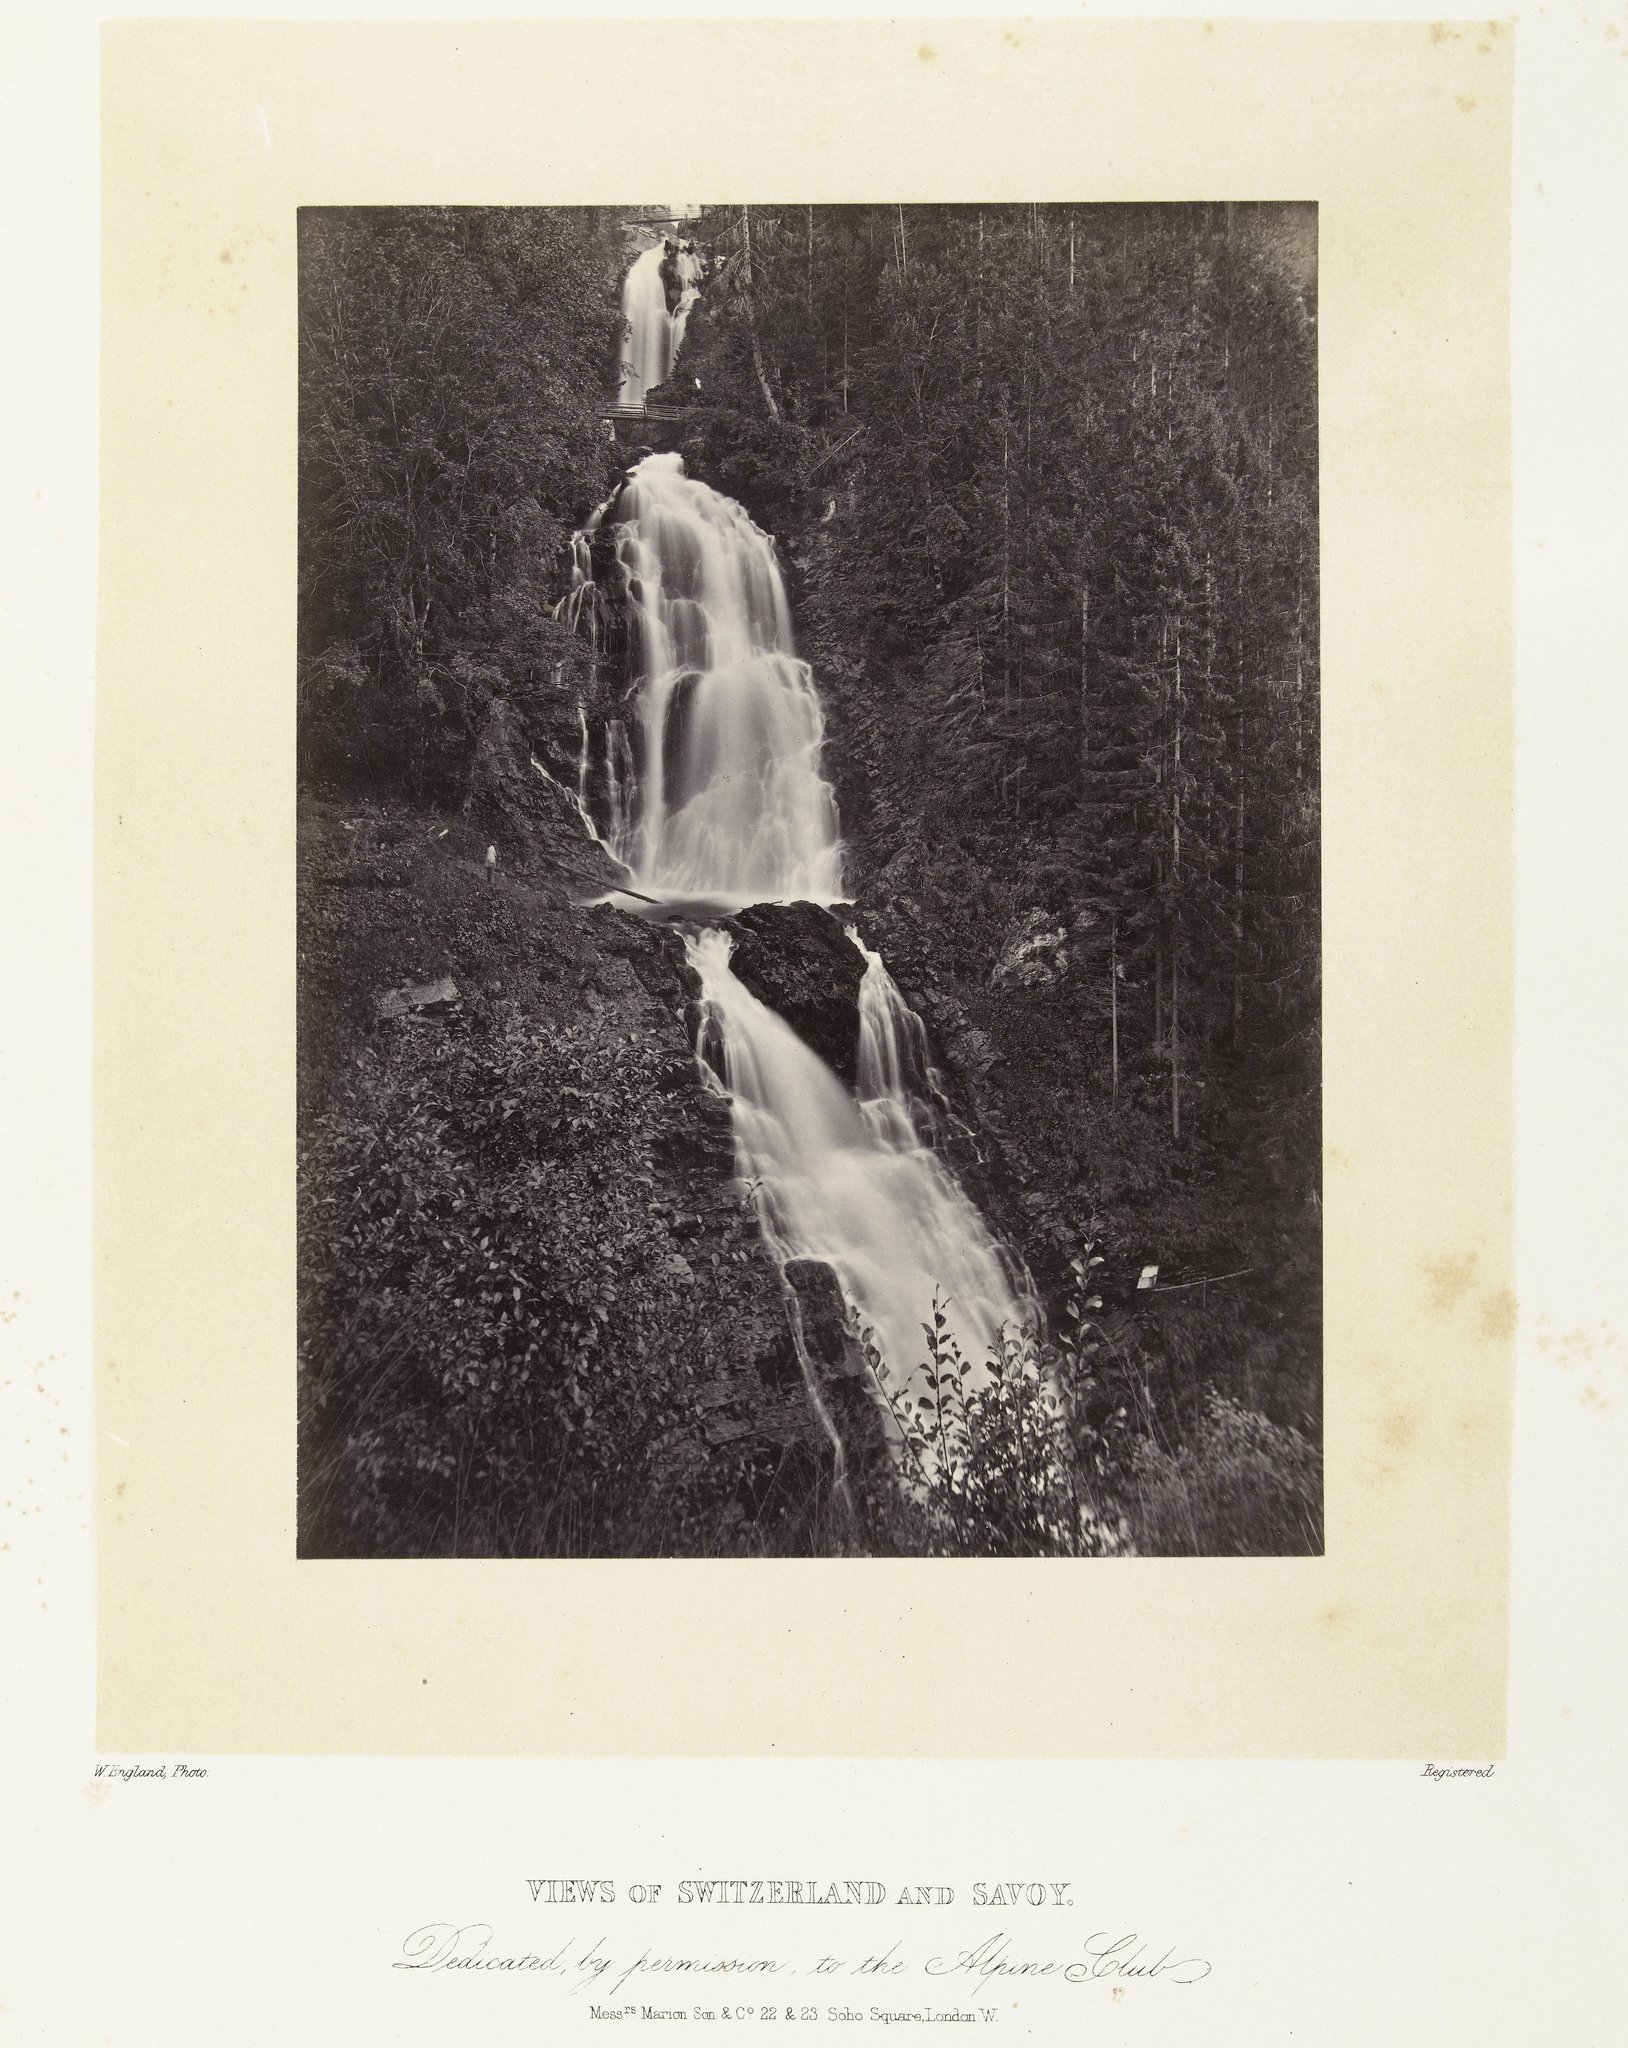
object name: photograph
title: Views of Switzerland and Savoy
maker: william england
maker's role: fotograaf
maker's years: 1816-1896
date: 1863-1865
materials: cardboard, paper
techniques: albumen print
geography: bern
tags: waterfall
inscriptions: inscription: ‘Dedicated, by permission, to the Alpine Club’, inscription: ‘Registered’, address: ‘Messrs Marion & Co 22 & 23 Soho Square, London W.’